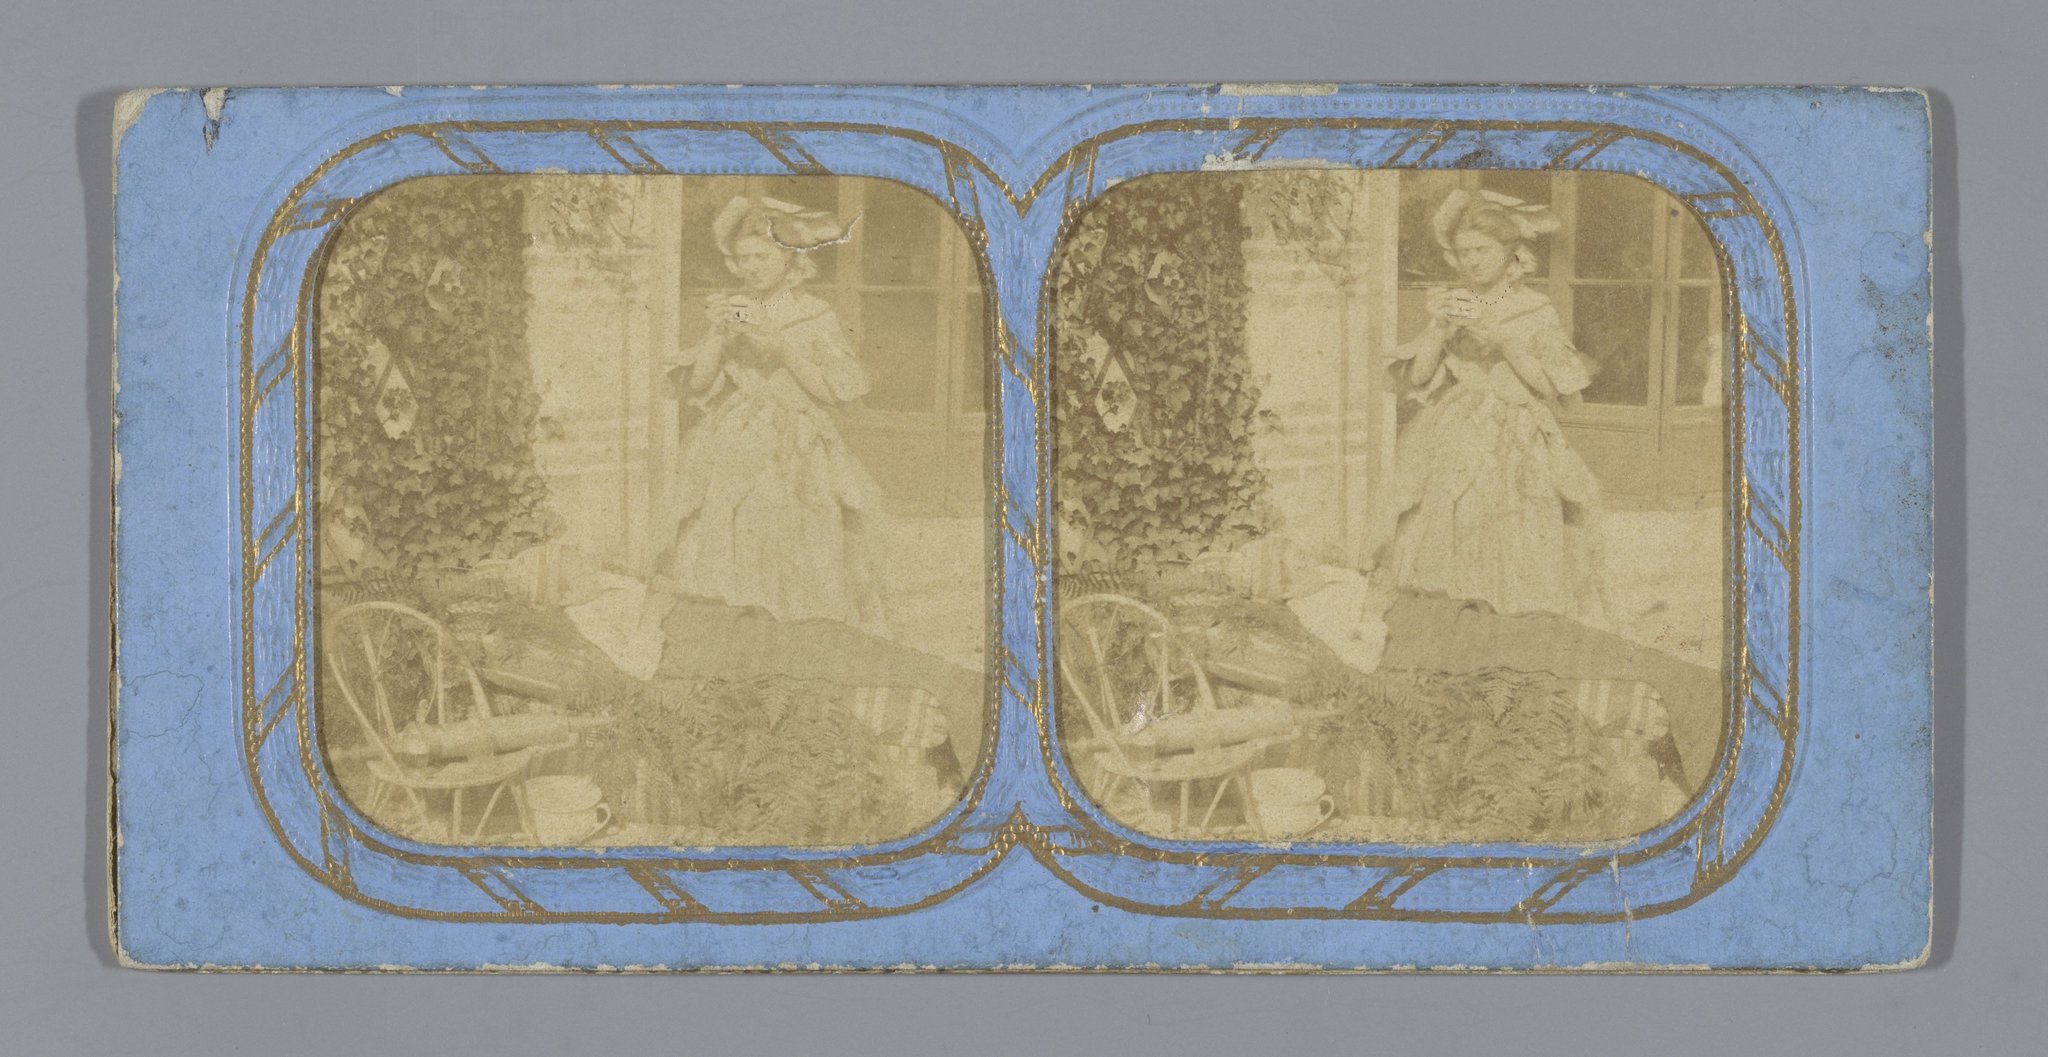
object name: tissue stereograph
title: Vrouw en kind op bed in tuin, de vrouw houdt mogelijk een camera vast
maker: Anonymous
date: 1855-1875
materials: cardboard, paper, photographic support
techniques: albumen print, cutting, hand coloring, perforating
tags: mother and baby or young child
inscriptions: number: ‘25’